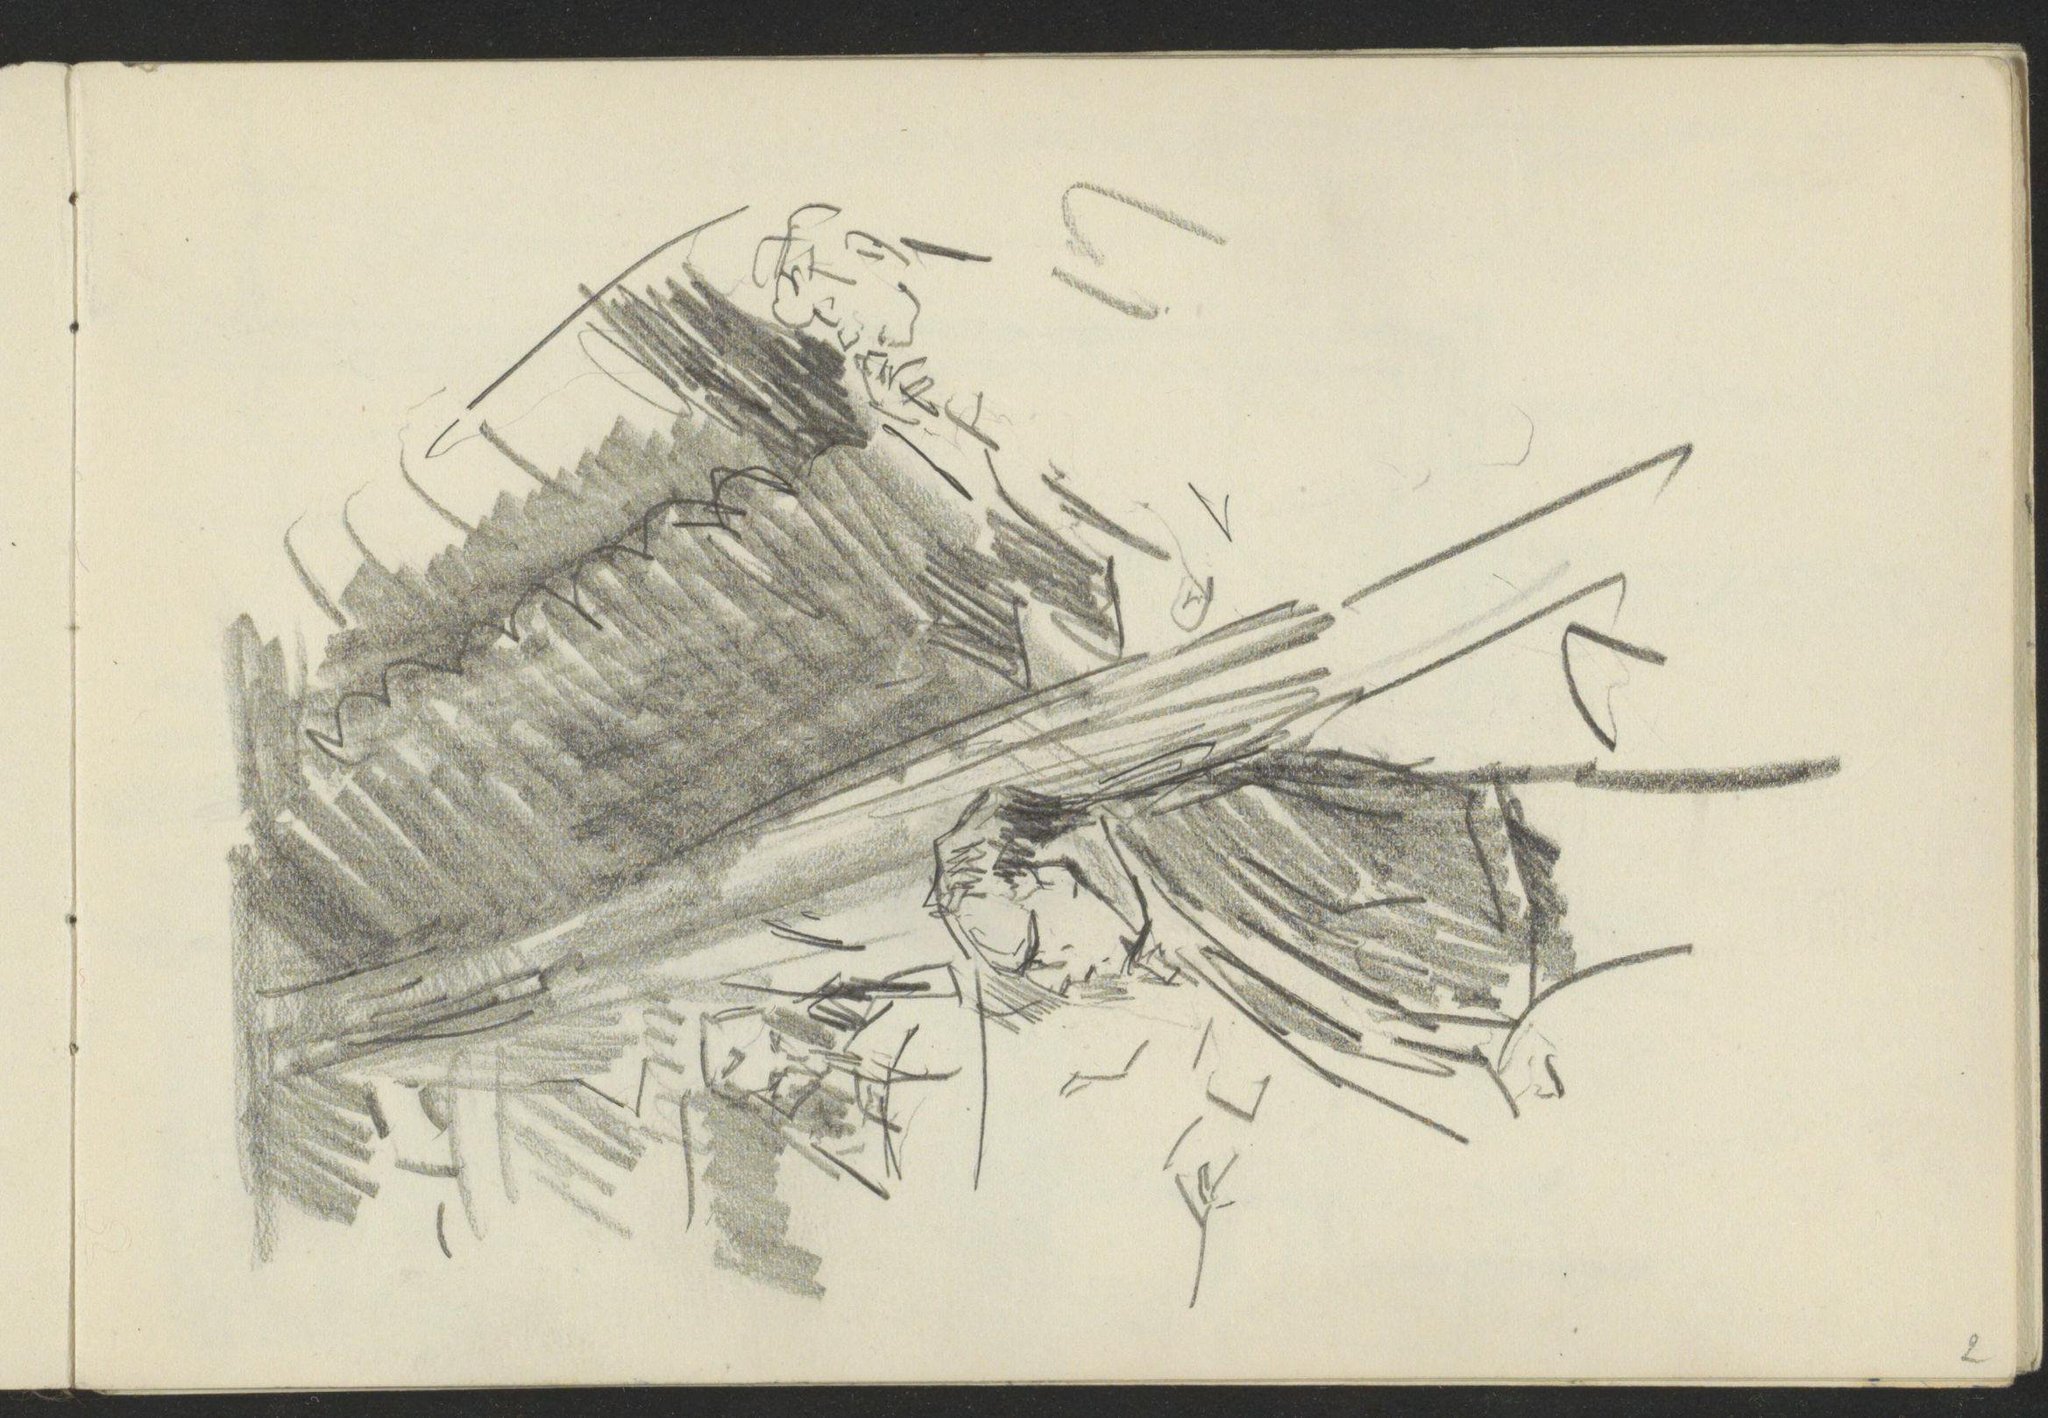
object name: sketchbook leaf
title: Dirigent in een orkestbak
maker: isaac israels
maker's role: draughtsman, painter, print maker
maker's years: 1865-1934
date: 1875-1934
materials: paper, pencil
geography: the hague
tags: large group of musicians, orchestra, wind instruments (+ artist at work), the audience ~ art performance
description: Naast hem een blazer en achter hem een toehoorder. Blad 2 recto uit schetsboek LXI met 20 bladen.